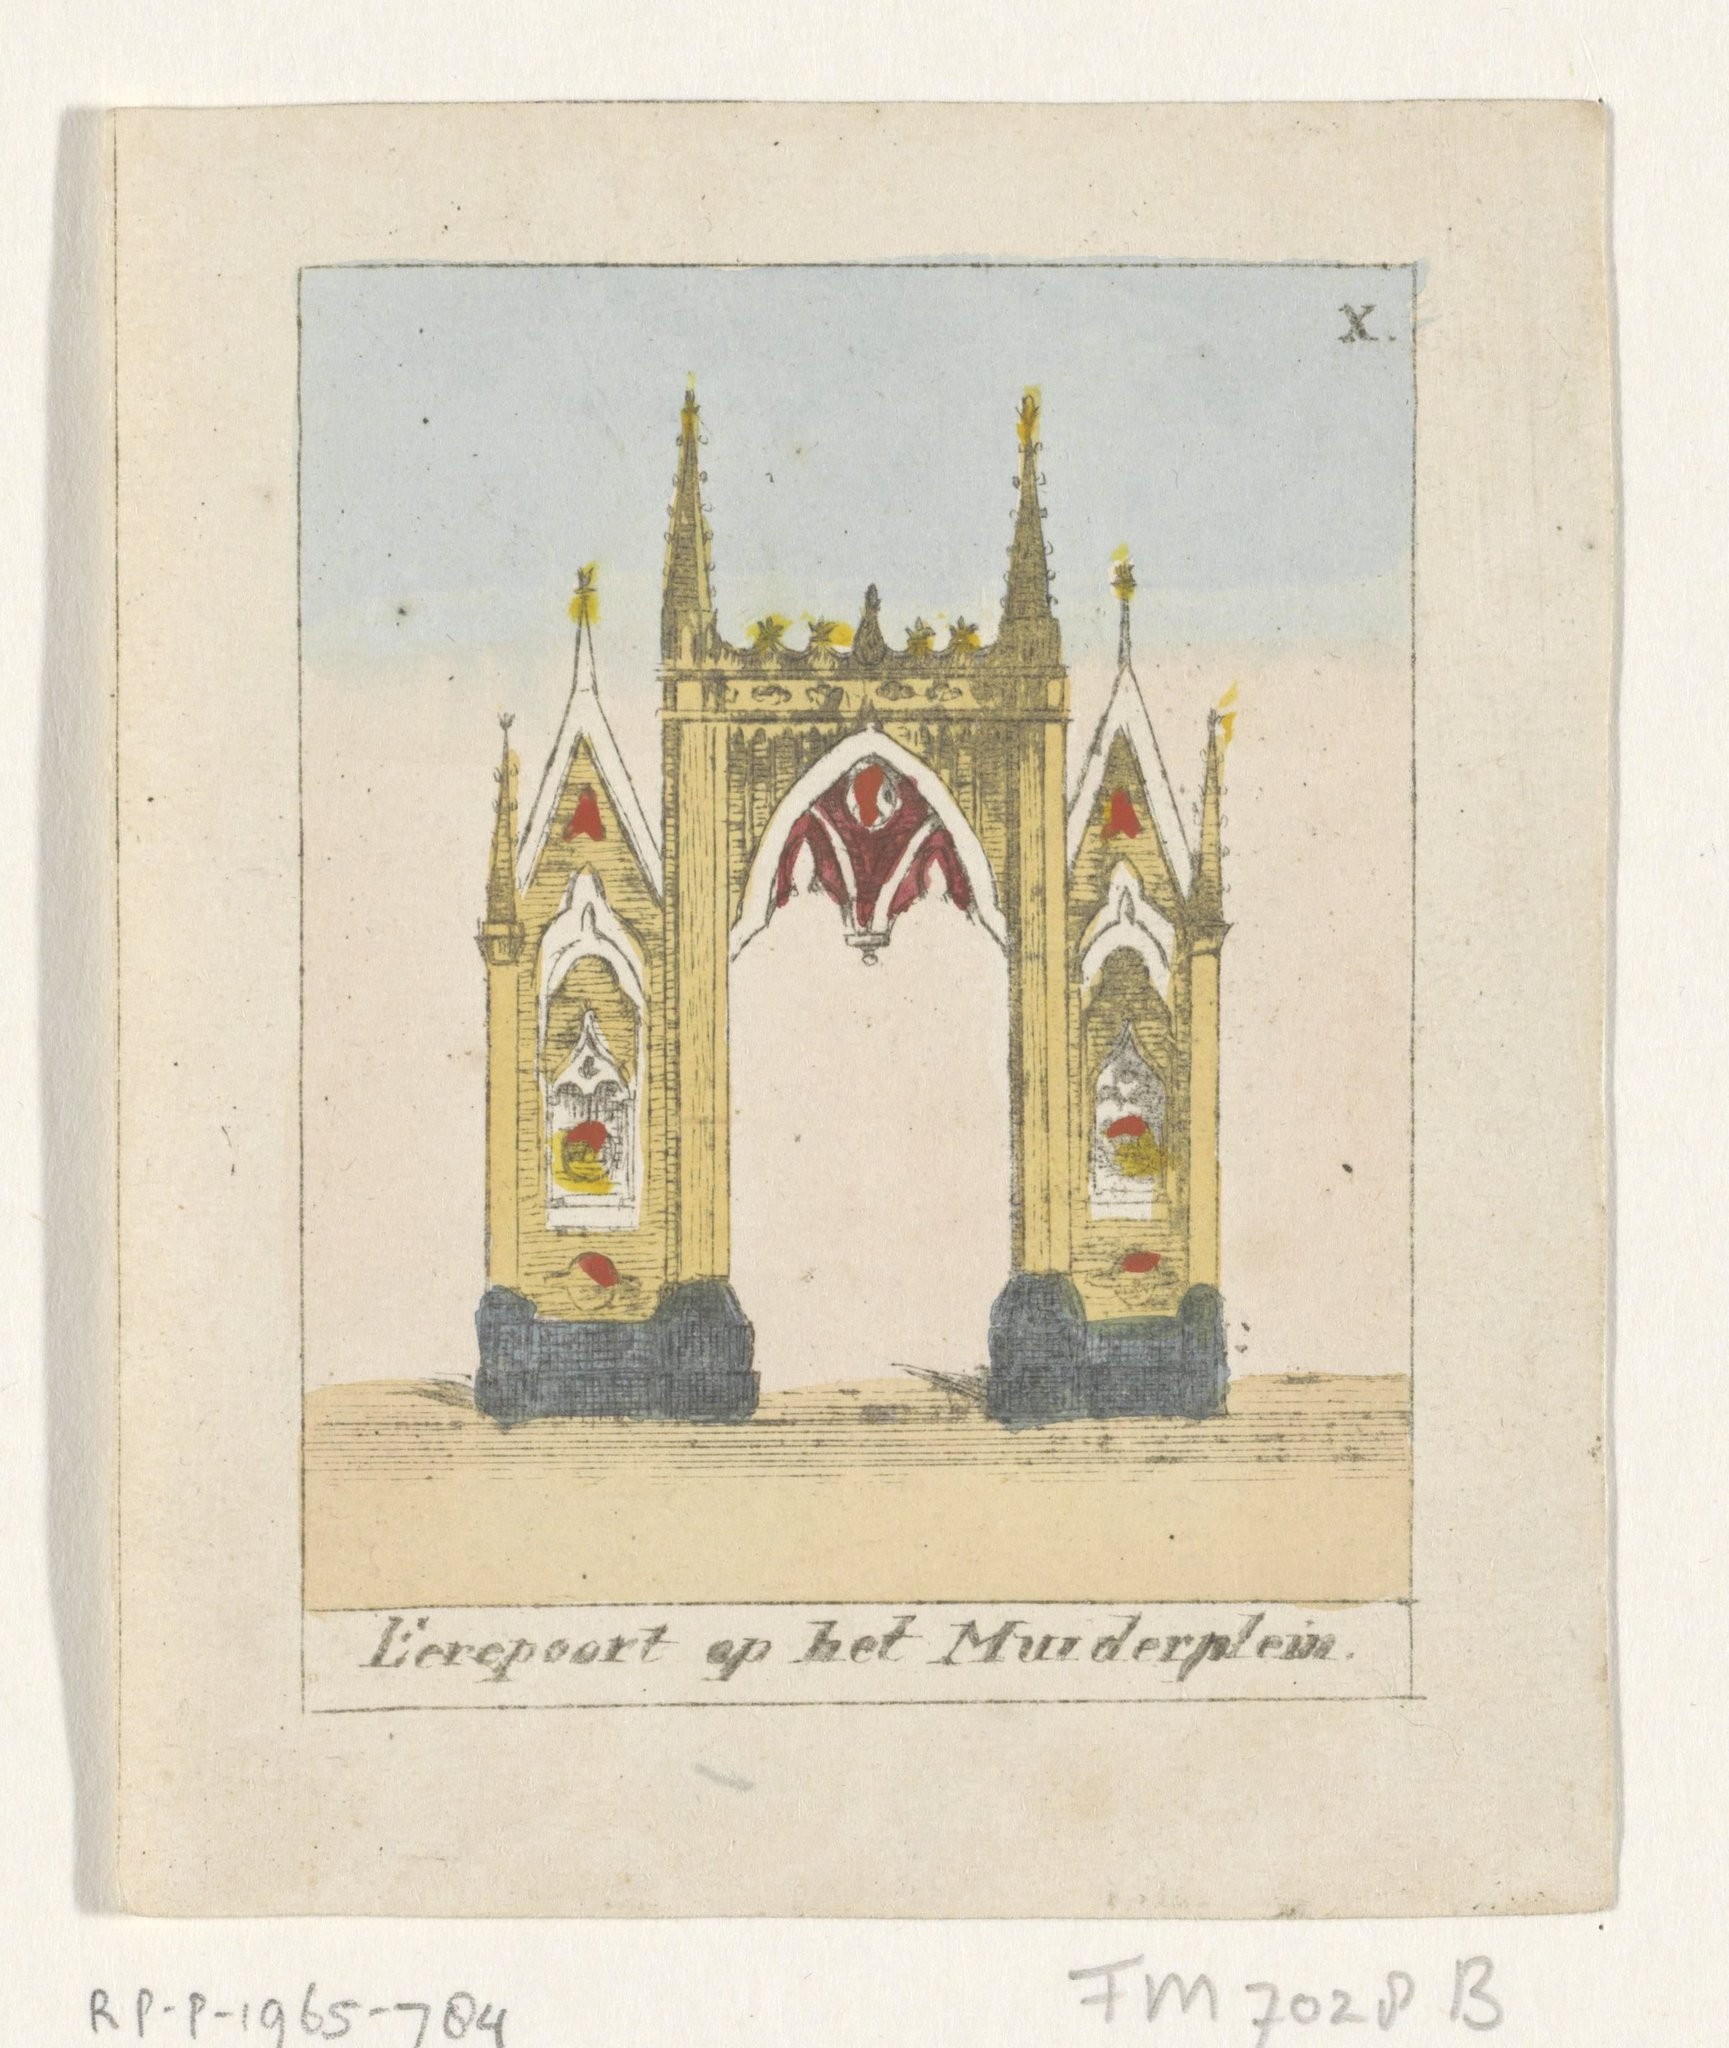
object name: print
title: Herinnerings Geschenkje aan 1840, voor de Nederlandsche Jeugd, ter gedachtenis aan de Plegtige Inhuldiging van Z.M. Koning Willem II. Met XII plaatjes waarop het merkwaardigste is voorgesteld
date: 1840-1841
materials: paper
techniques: hand coloring, lithograph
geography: amsterdam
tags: the hague, william ii of the netherlands, other forms of installation, triumphal arch, amsterdam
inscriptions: collector's mark: Lugt 2228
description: Erepoort opgericht op het Muiderplein. Onderdeel van mapje met een serie van twaalf prentjes van de intocht van Willem II, de erepoorten opgericht in de stad en de inhuldiging op 28 november 1840 in de Nieuwe Kerk te Amsterdam.